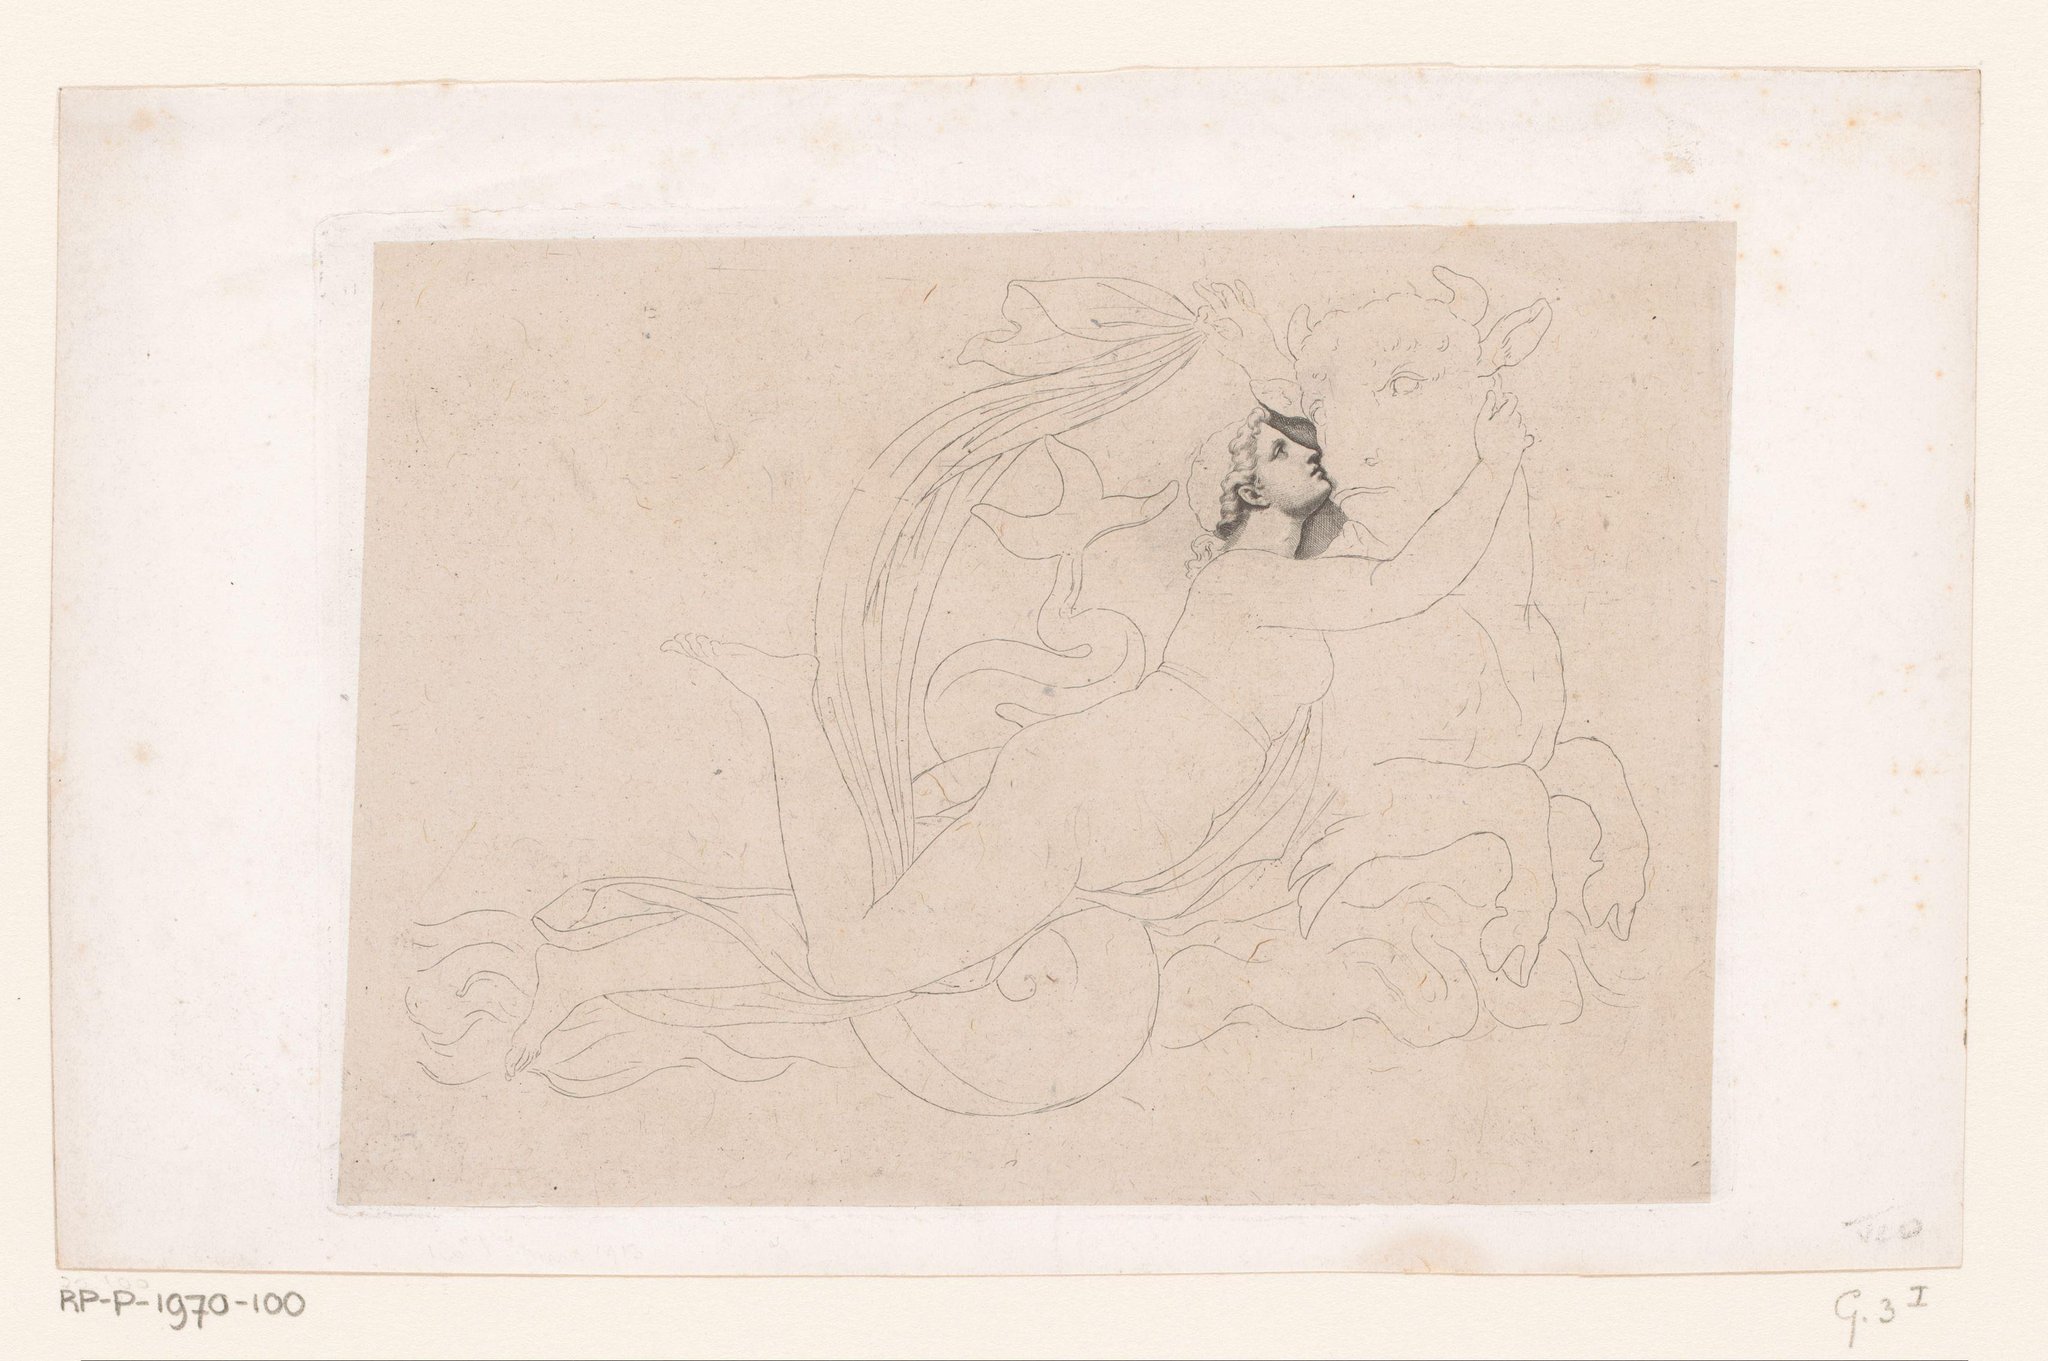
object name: print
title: Ontvoering van Europa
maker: pierre prudhon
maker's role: draughtsman, painter, print maker, publisher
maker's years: 1758-1823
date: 1768-1823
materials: paper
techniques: etching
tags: jupiter, usually in the shape of a white bull, abducts europa and carries her across the water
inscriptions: collector's mark: Lugt 2760, collector's mark: Lugt 2228